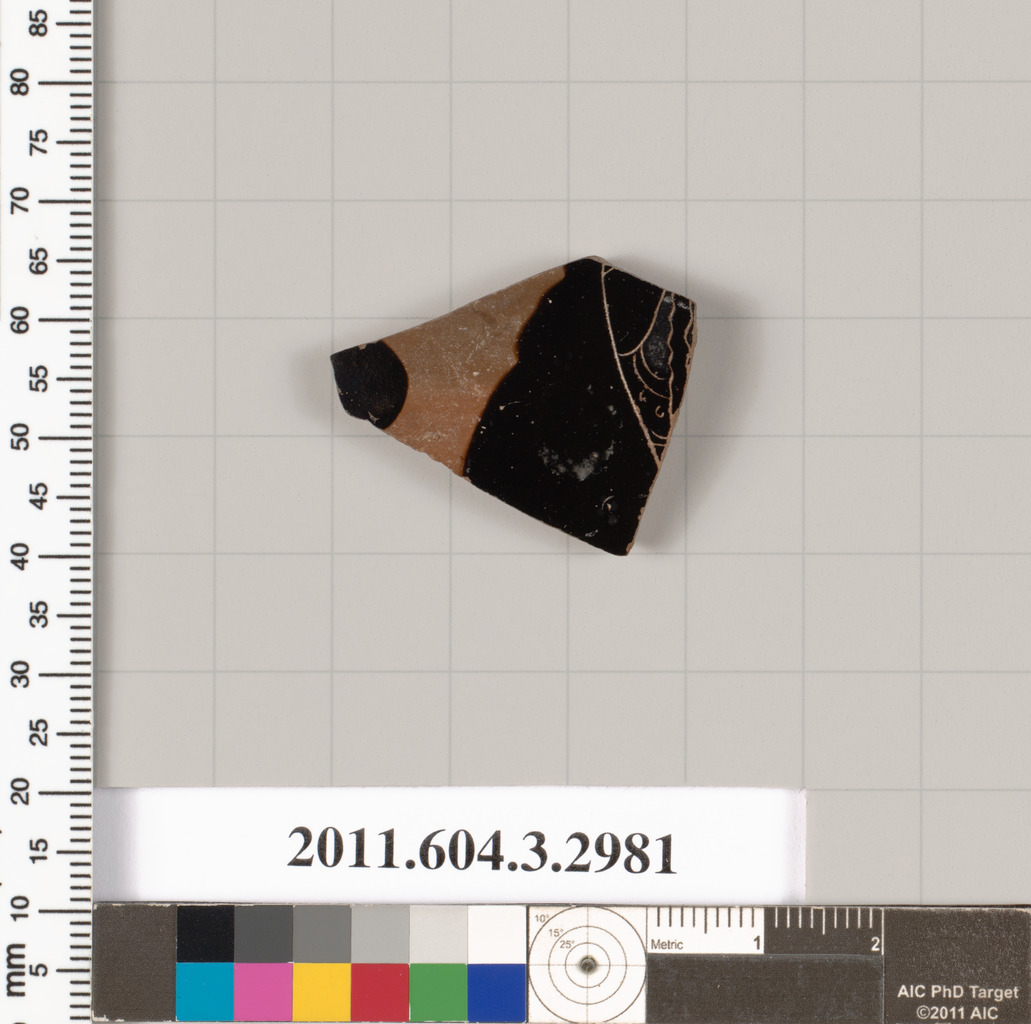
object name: undetermined closed shape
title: Terracotta fragment from a closed shape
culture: greek, attic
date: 534-468 BCE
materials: terracotta